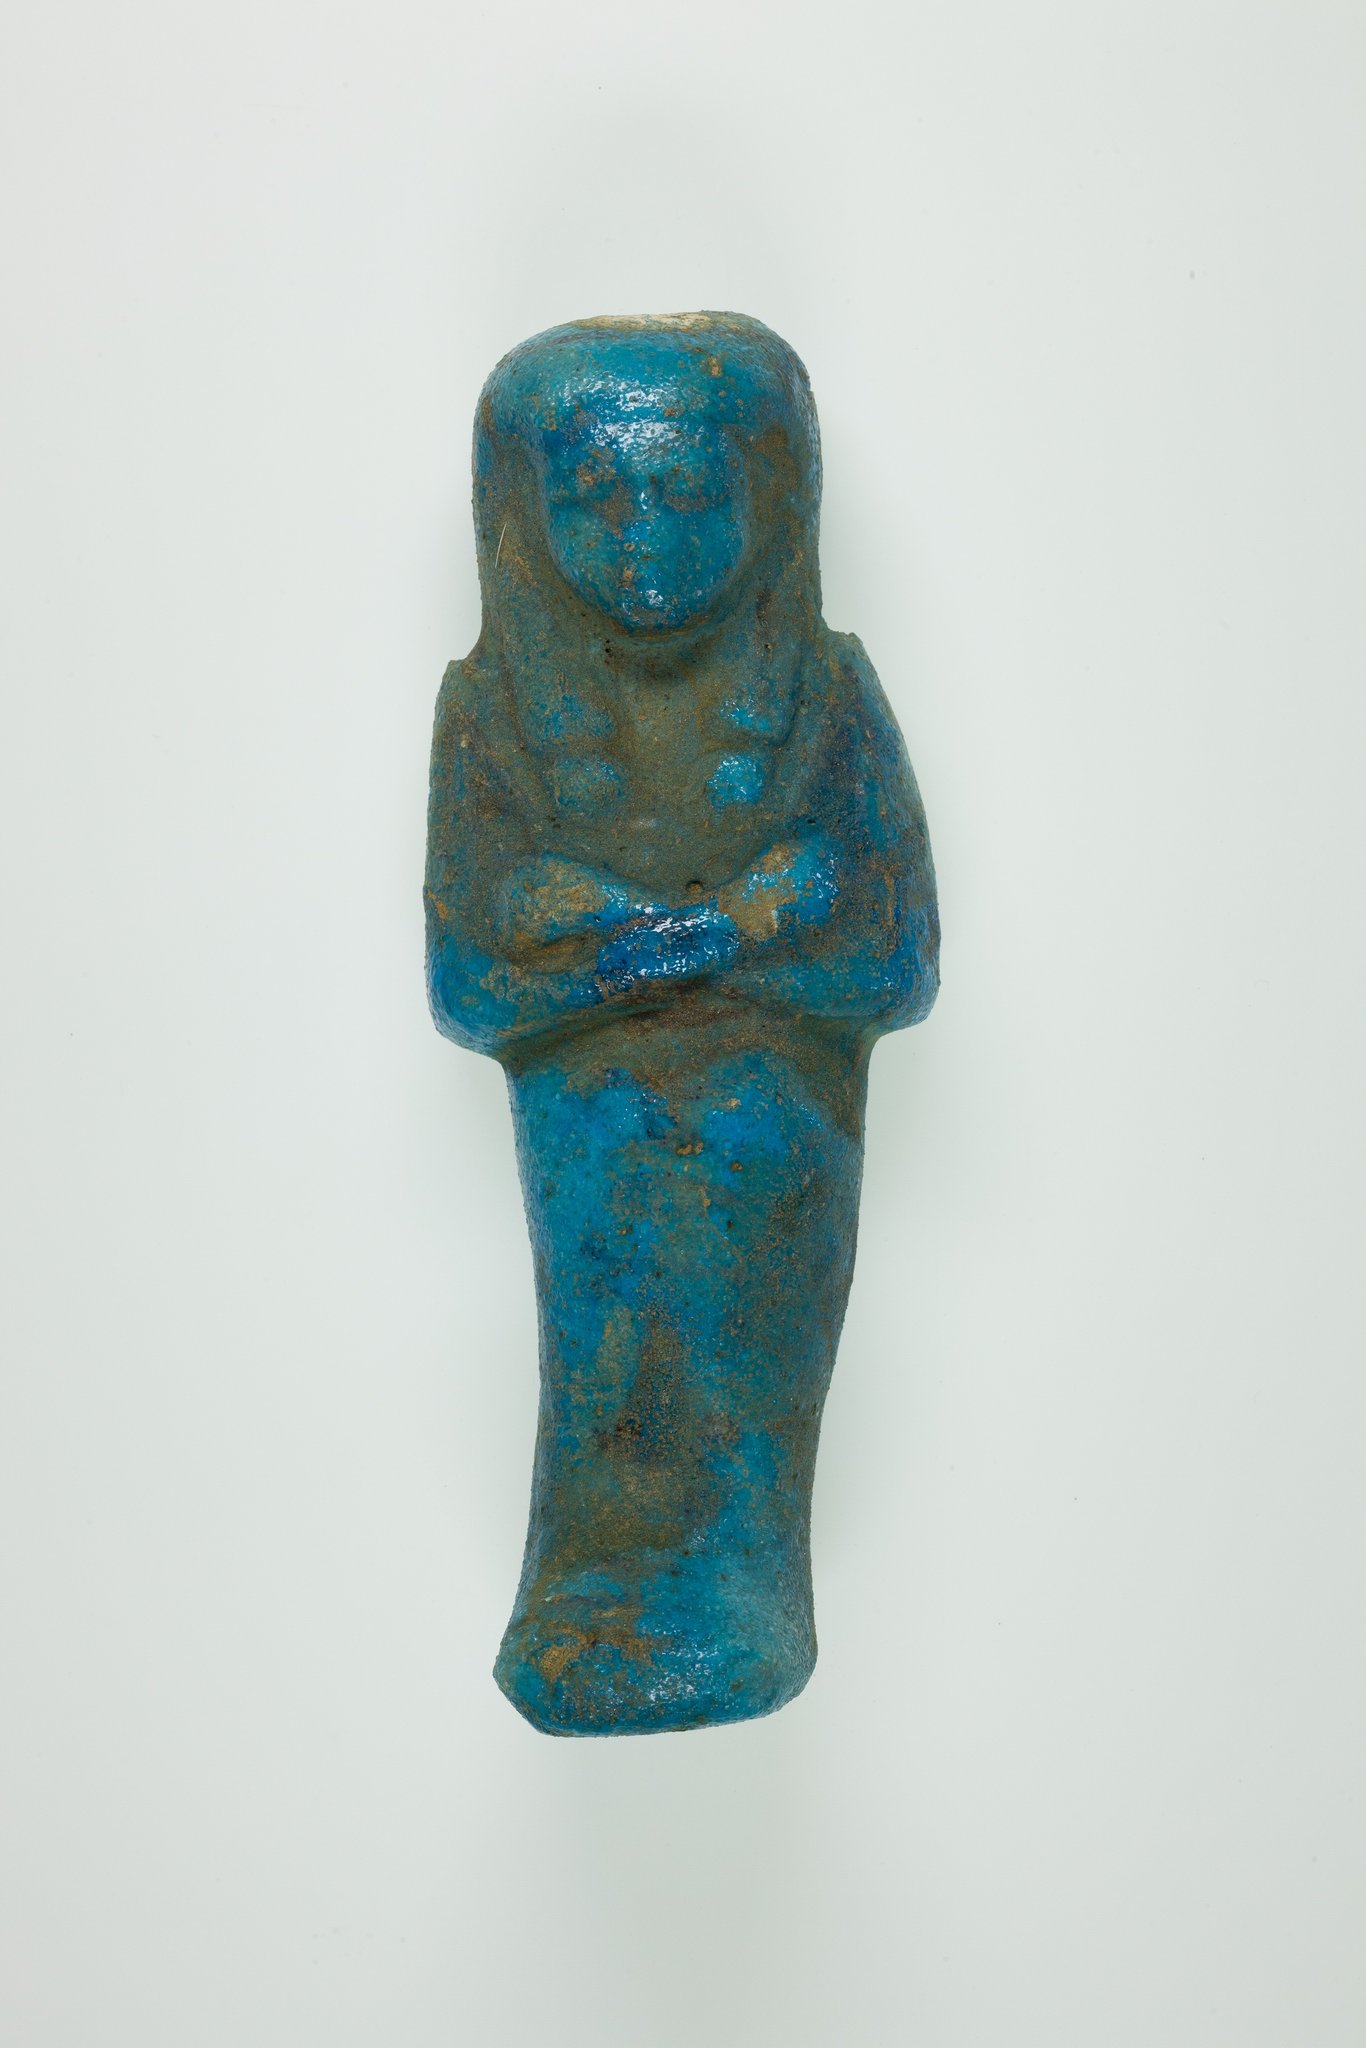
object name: worker shabti, henettawy c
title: Worker Shabti of Henettawy (C), Daughter of Isetemkheb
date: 990-970 BCE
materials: faience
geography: egypt